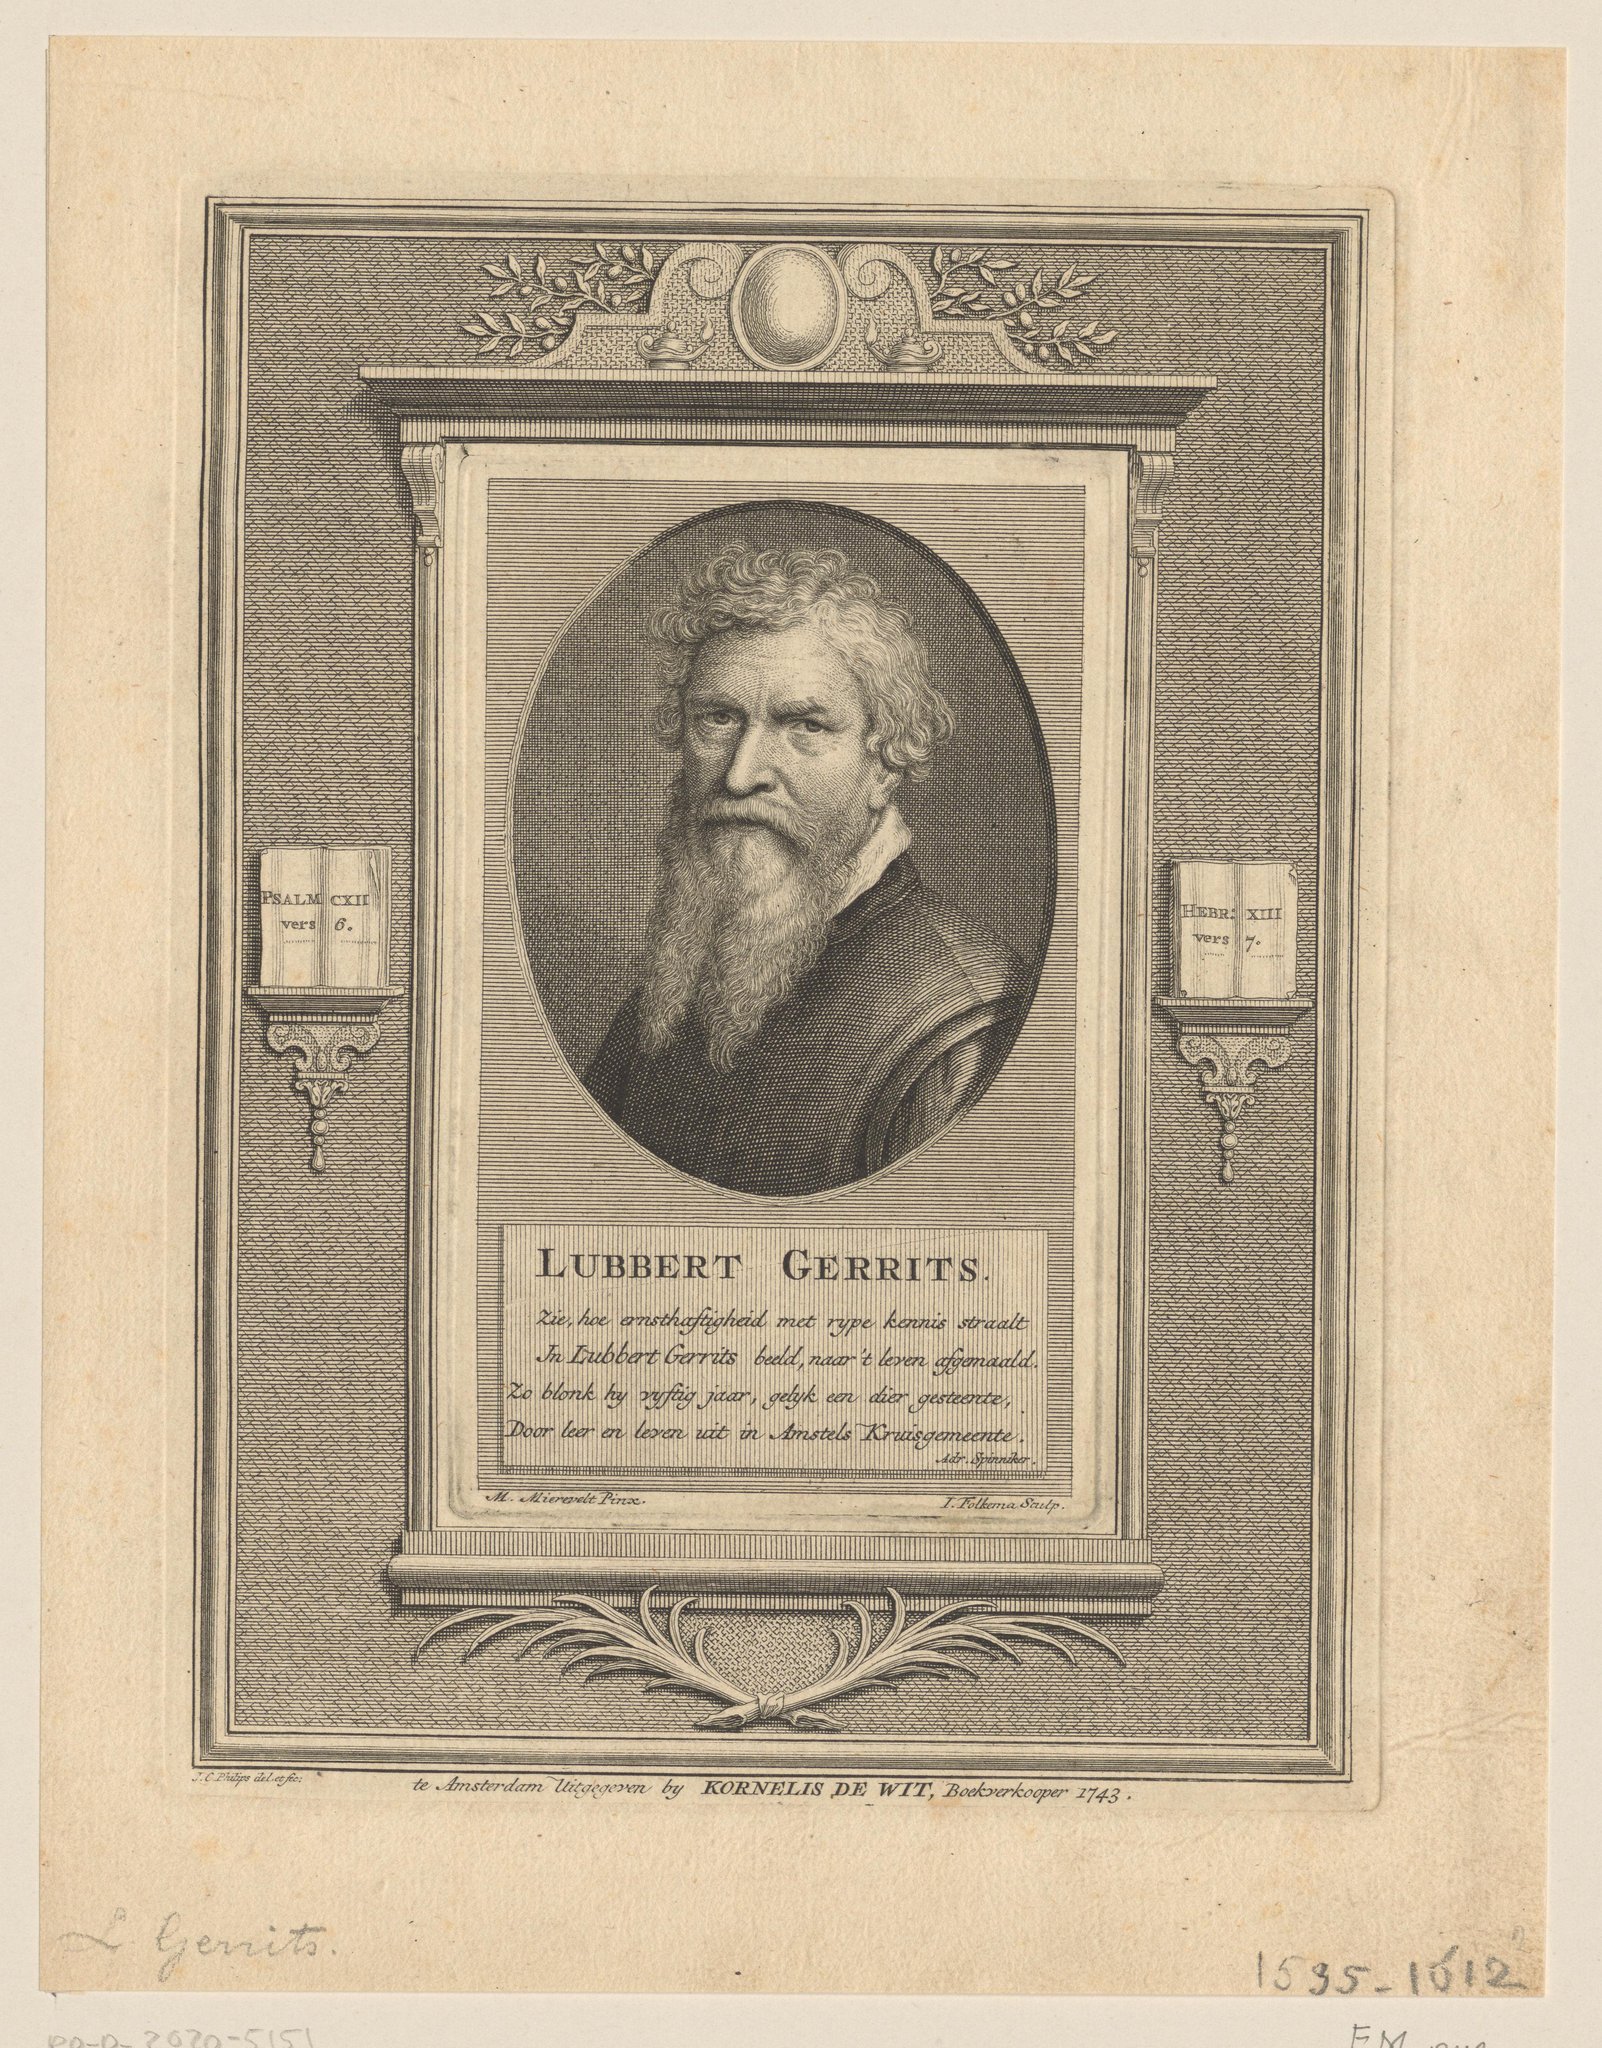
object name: print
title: Portret van Lubbert Gerrits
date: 1743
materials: paper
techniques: engraving, etching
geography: amsterdam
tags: amsterdam, theologian, historical persons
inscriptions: date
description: Prent uit: Schijn, Hermannus. Geschiedenis dier christenen, welke in de Vereenigde Nederlanden onder de protestanten mennoniten genaamd worden. Amsterdam: Kornelis de Wit, 1743.